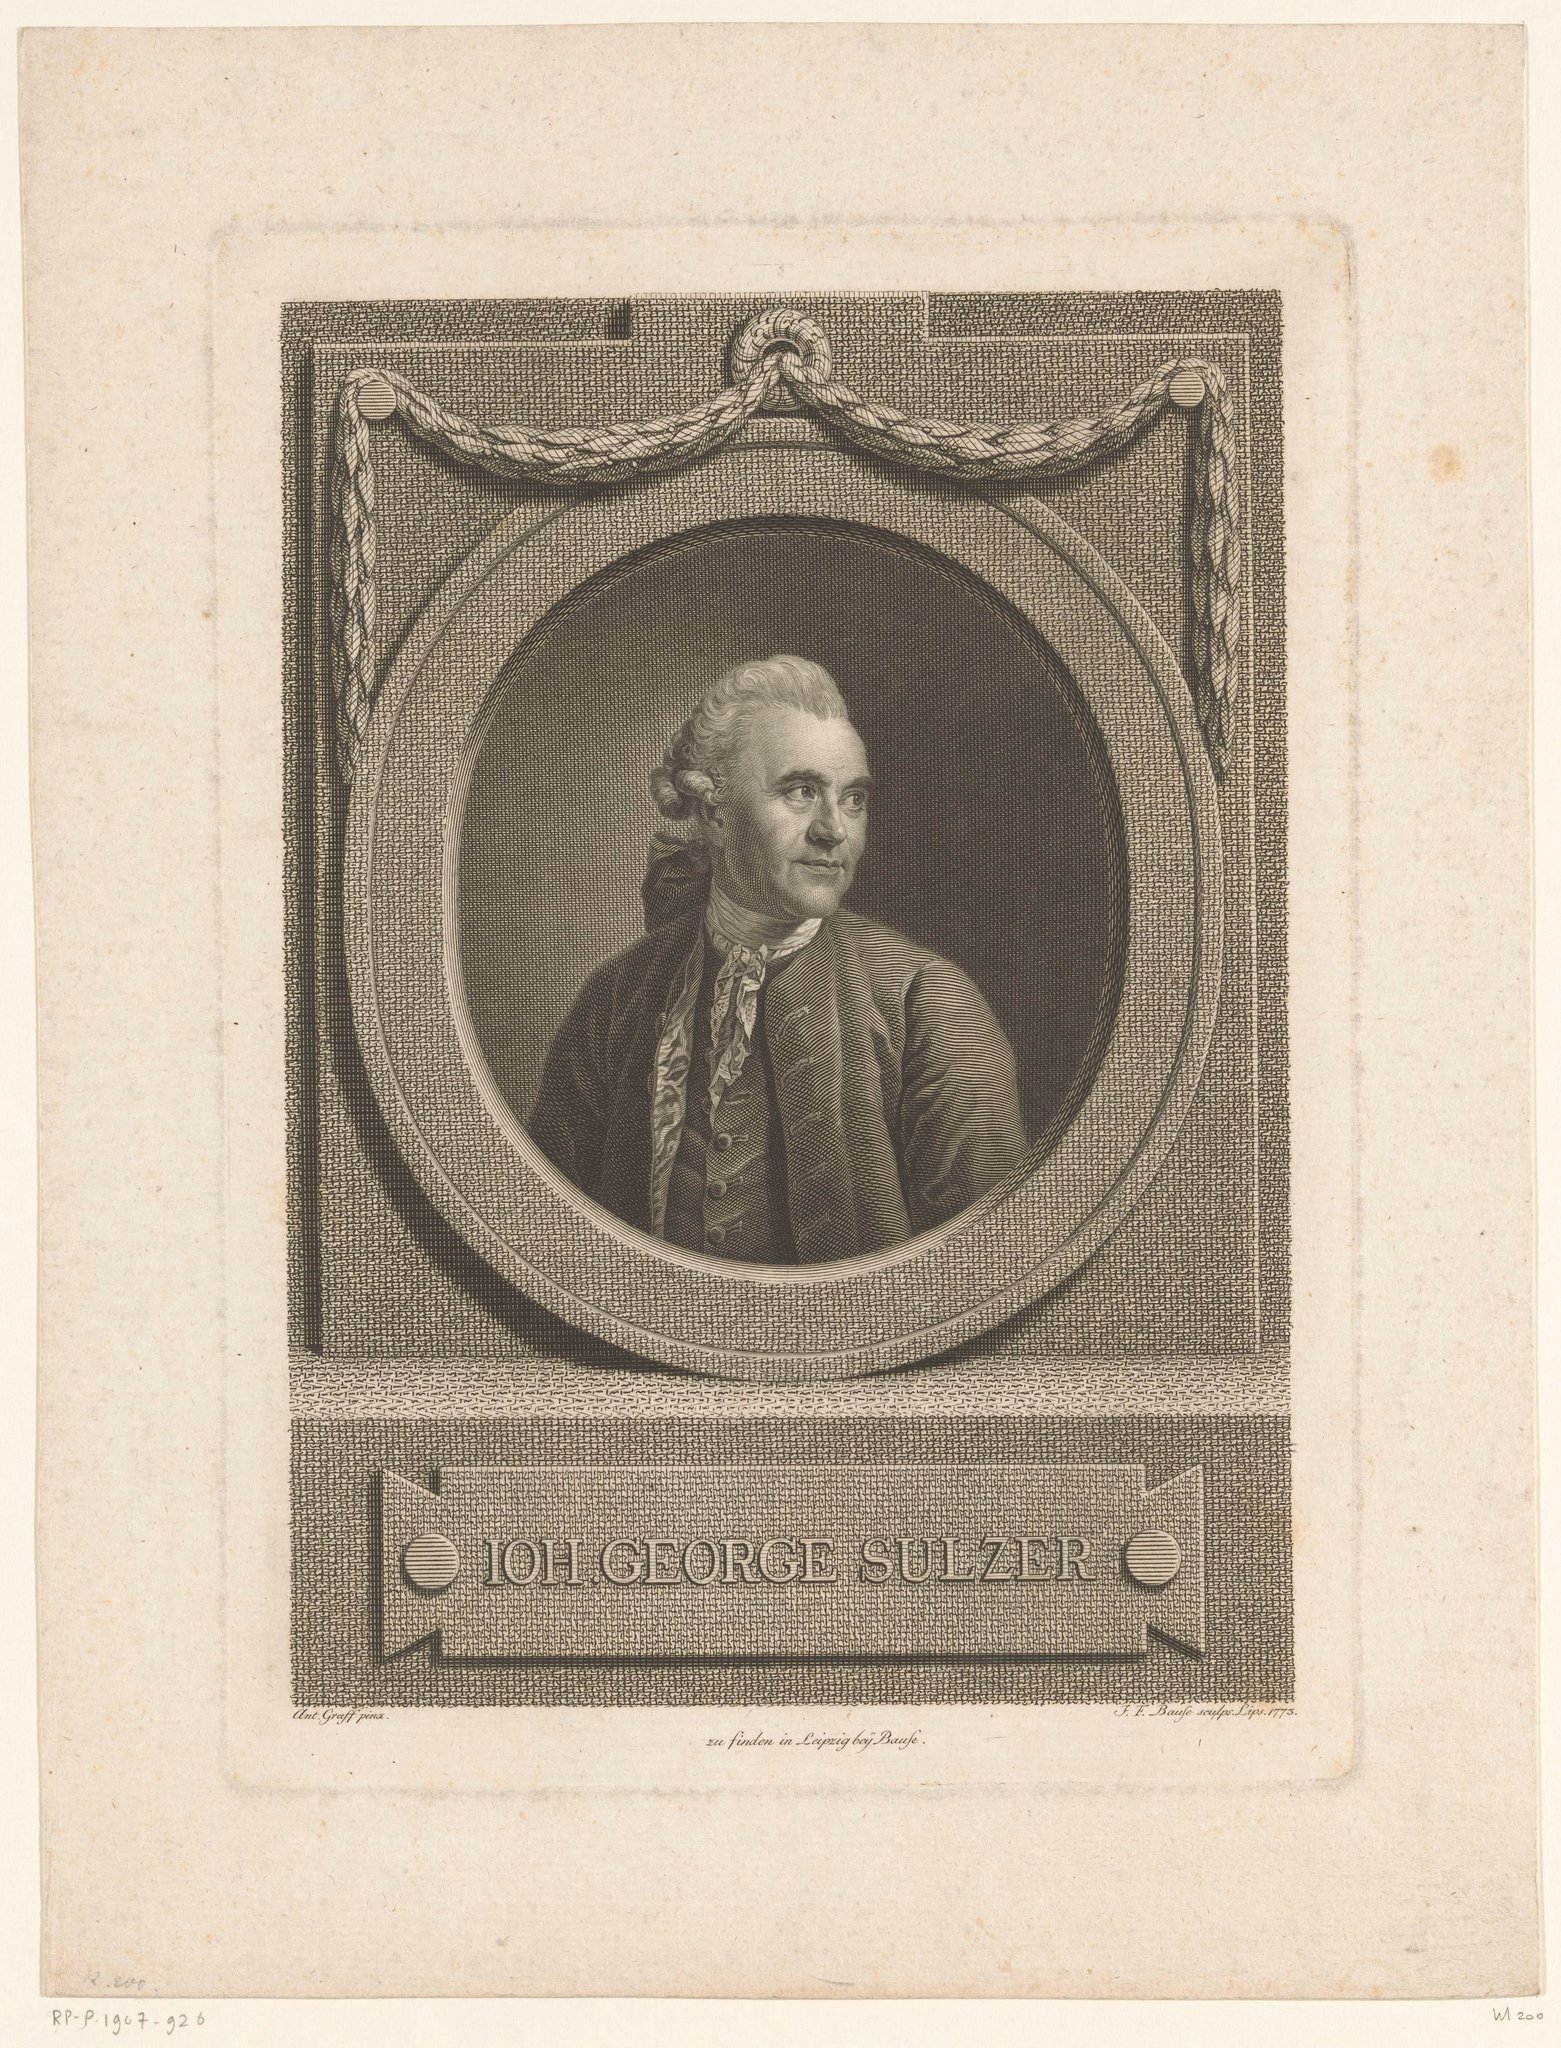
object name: print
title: Portret van Johann Georg Sulzer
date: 1773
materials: paper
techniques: engraving, etching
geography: leipzig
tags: berlin, historical persons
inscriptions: collector's mark: Lugt 2228